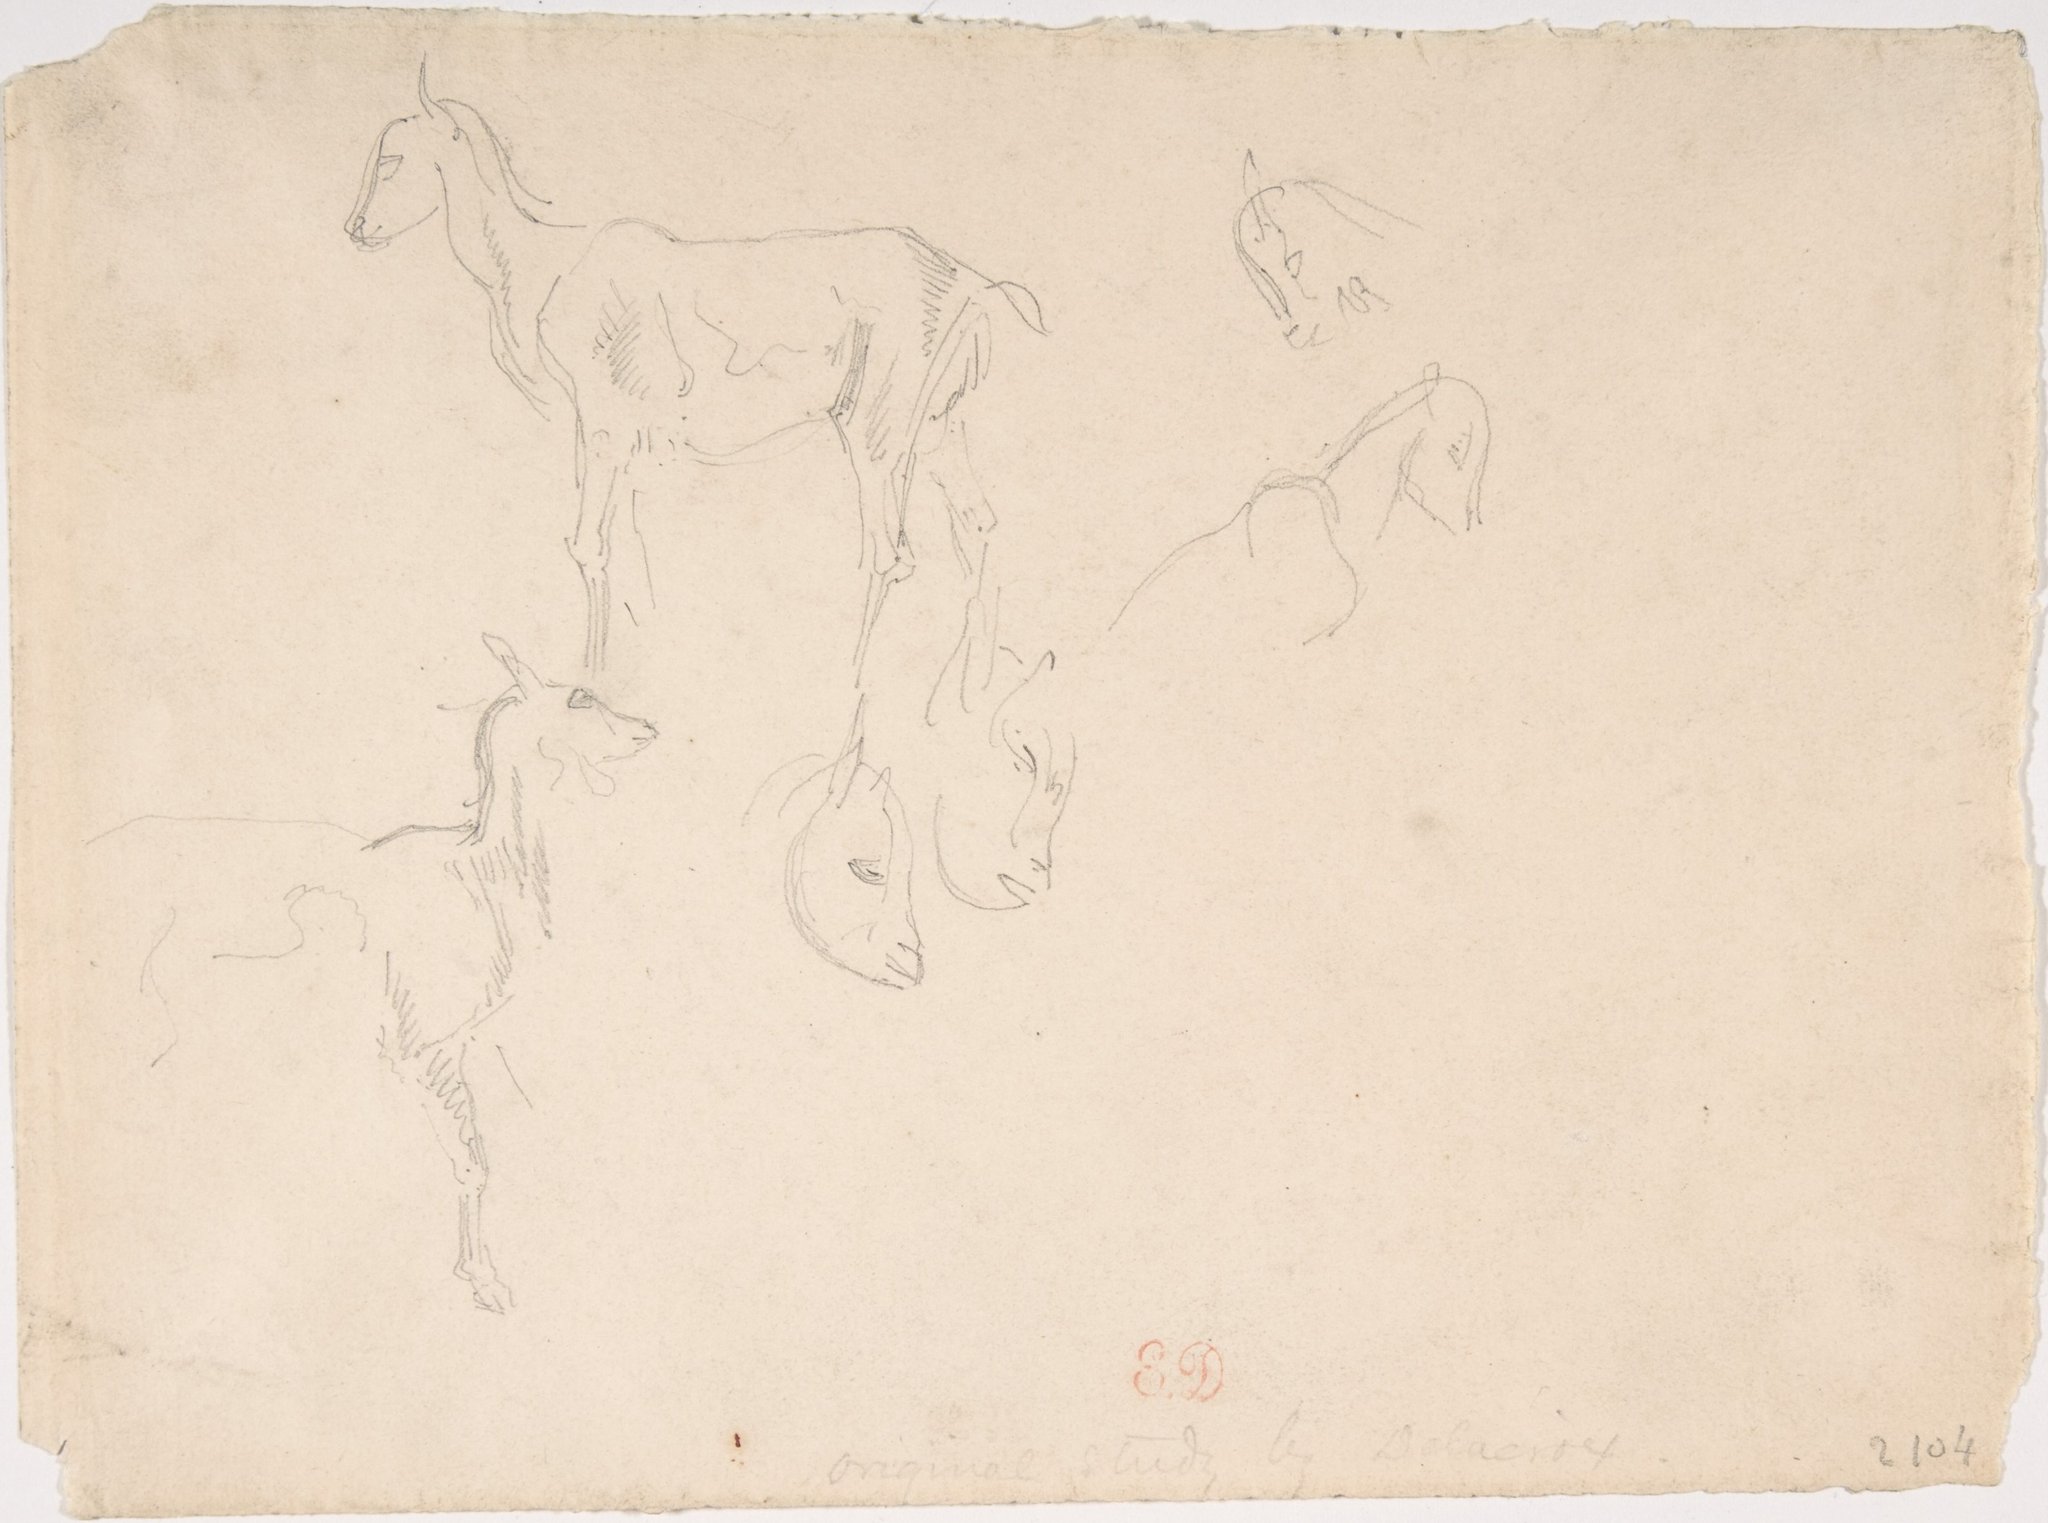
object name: drawing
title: Studies of a Goat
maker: eugène delacroix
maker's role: artist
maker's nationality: french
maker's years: 1798-1863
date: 1798-1863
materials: graphite, paper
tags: goats